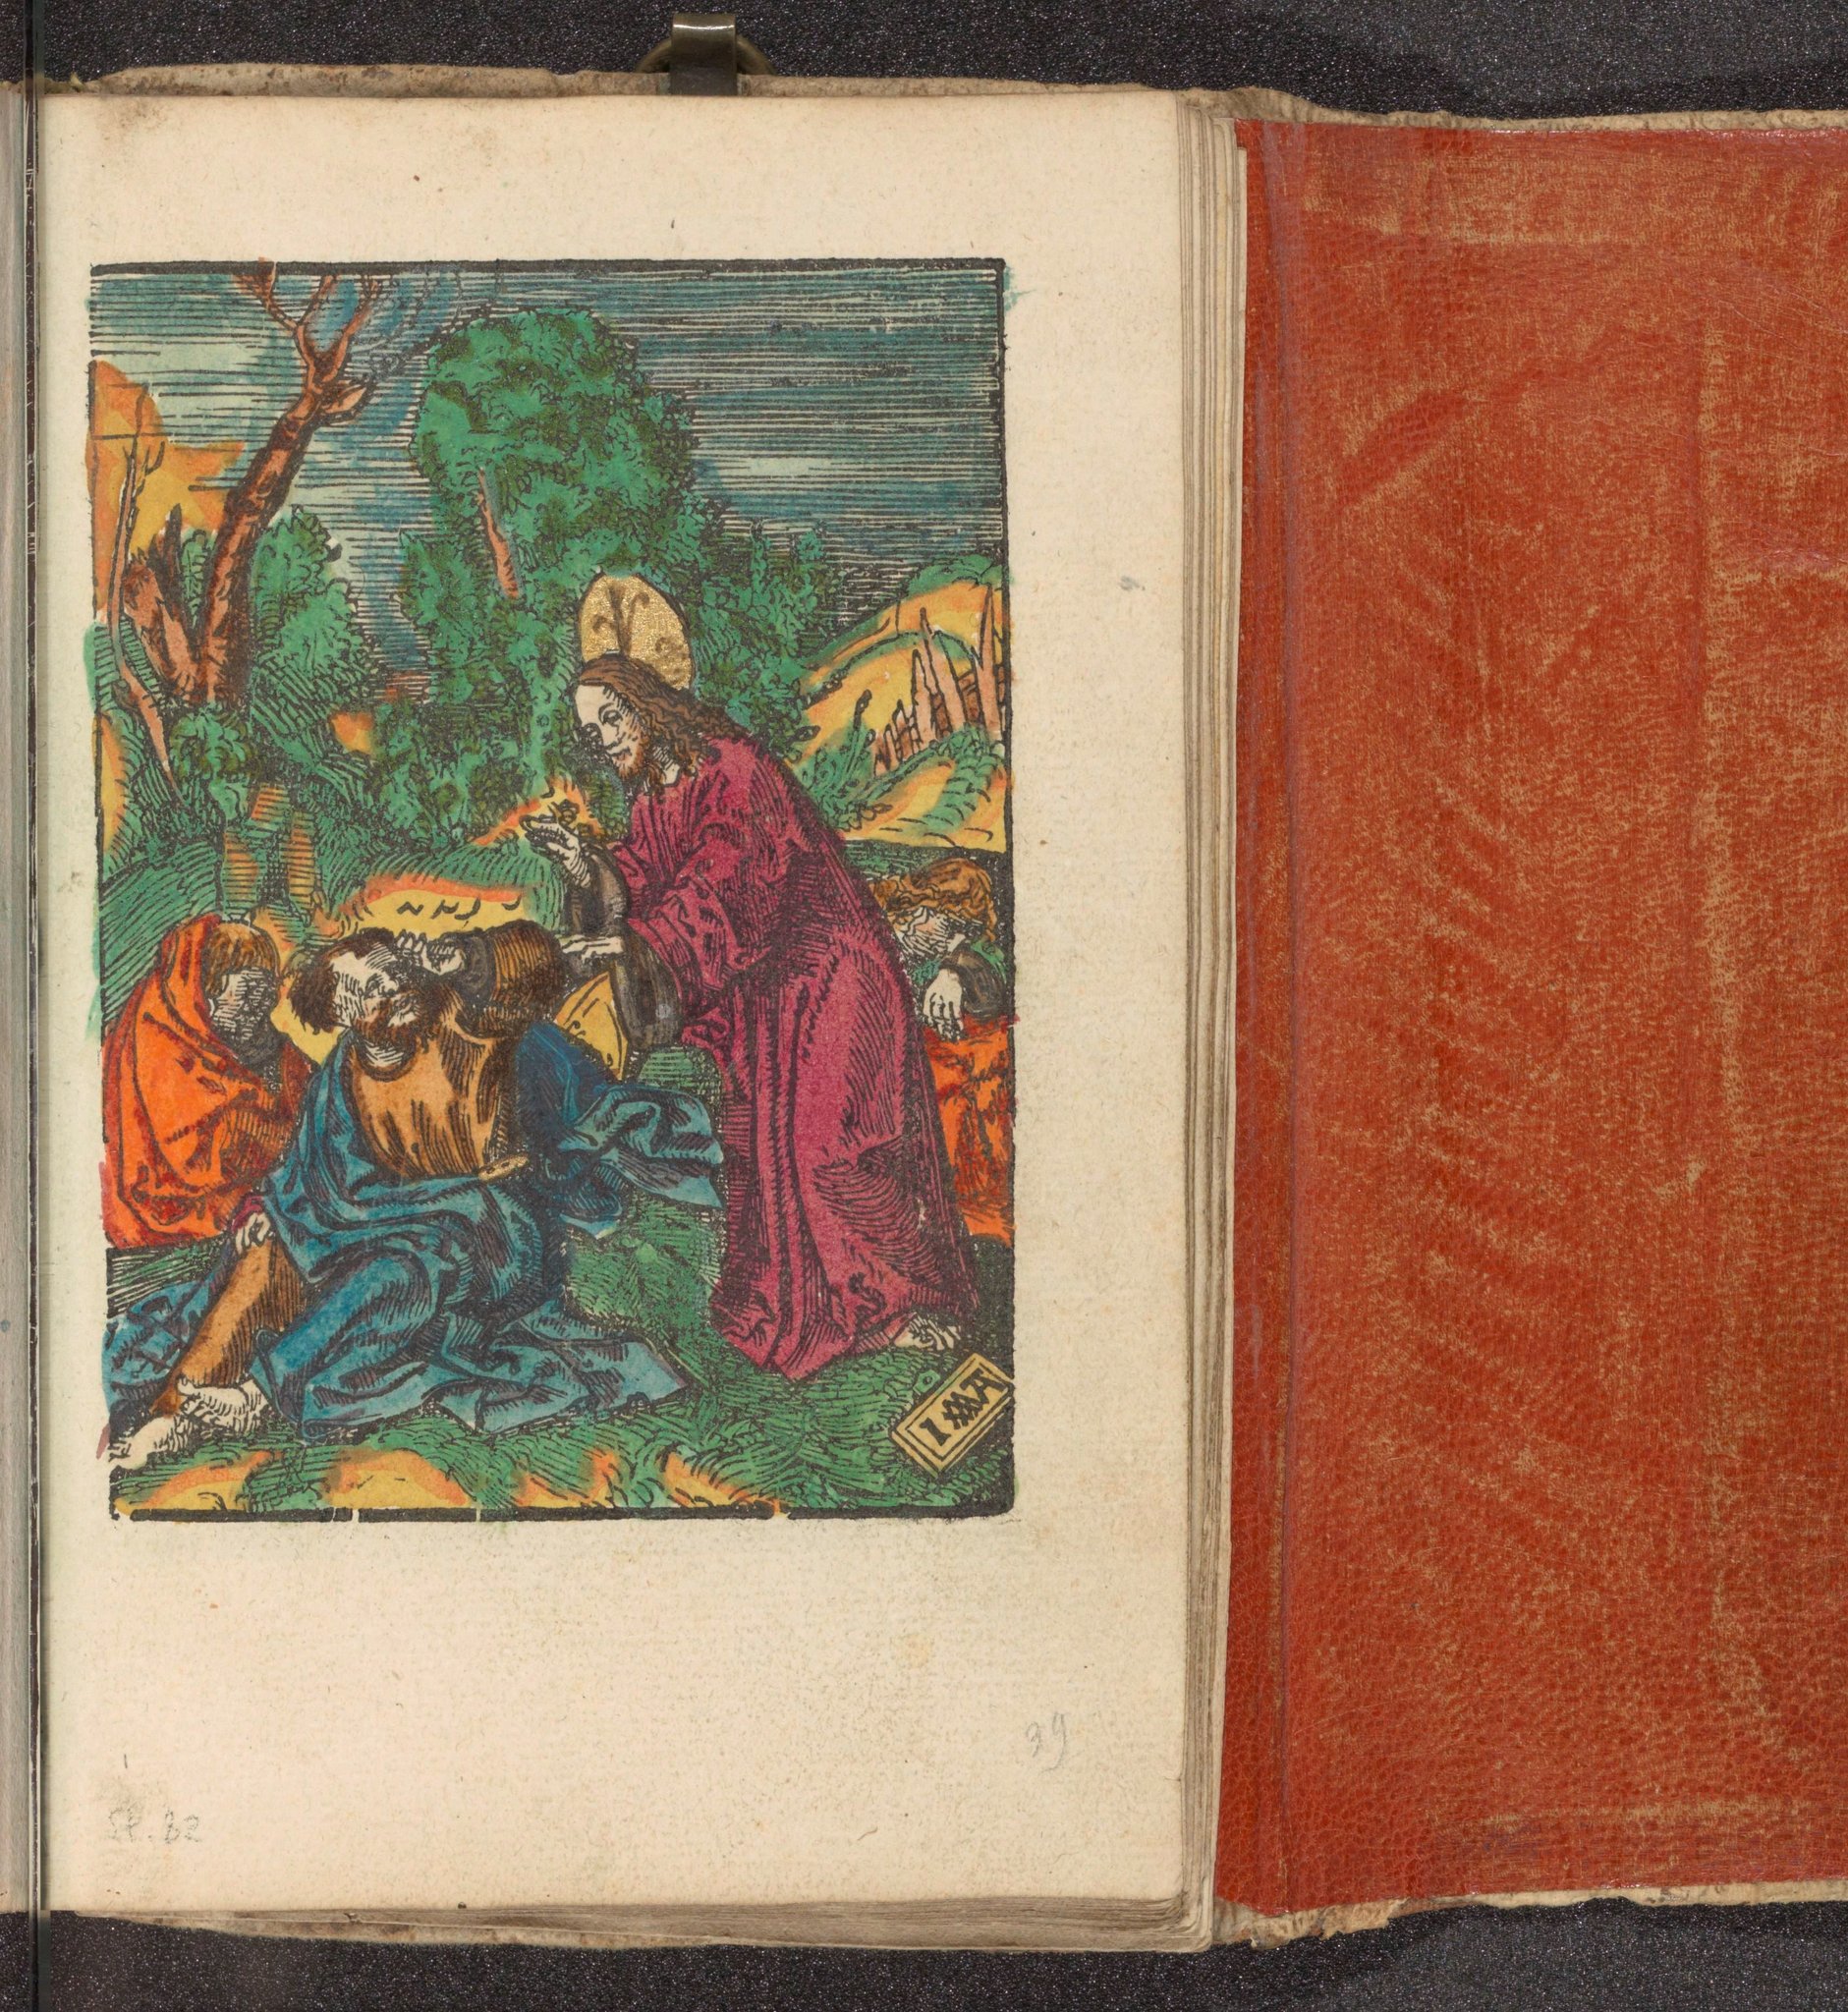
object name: album leaf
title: De kleine Passie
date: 1520-1521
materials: paper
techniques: hand coloring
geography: amsterdam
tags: agony of christ; three (or eleven) apostles sleeping, book in which illustrations are essential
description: Christus treft Petrus, Johannes en Andreas slapend aan in de hof van Getsemane, terwijl hij hen had gevraagd met hem te waken. Petrus wrijft in zijn ogen. Prent maakt deel uit van een boek.